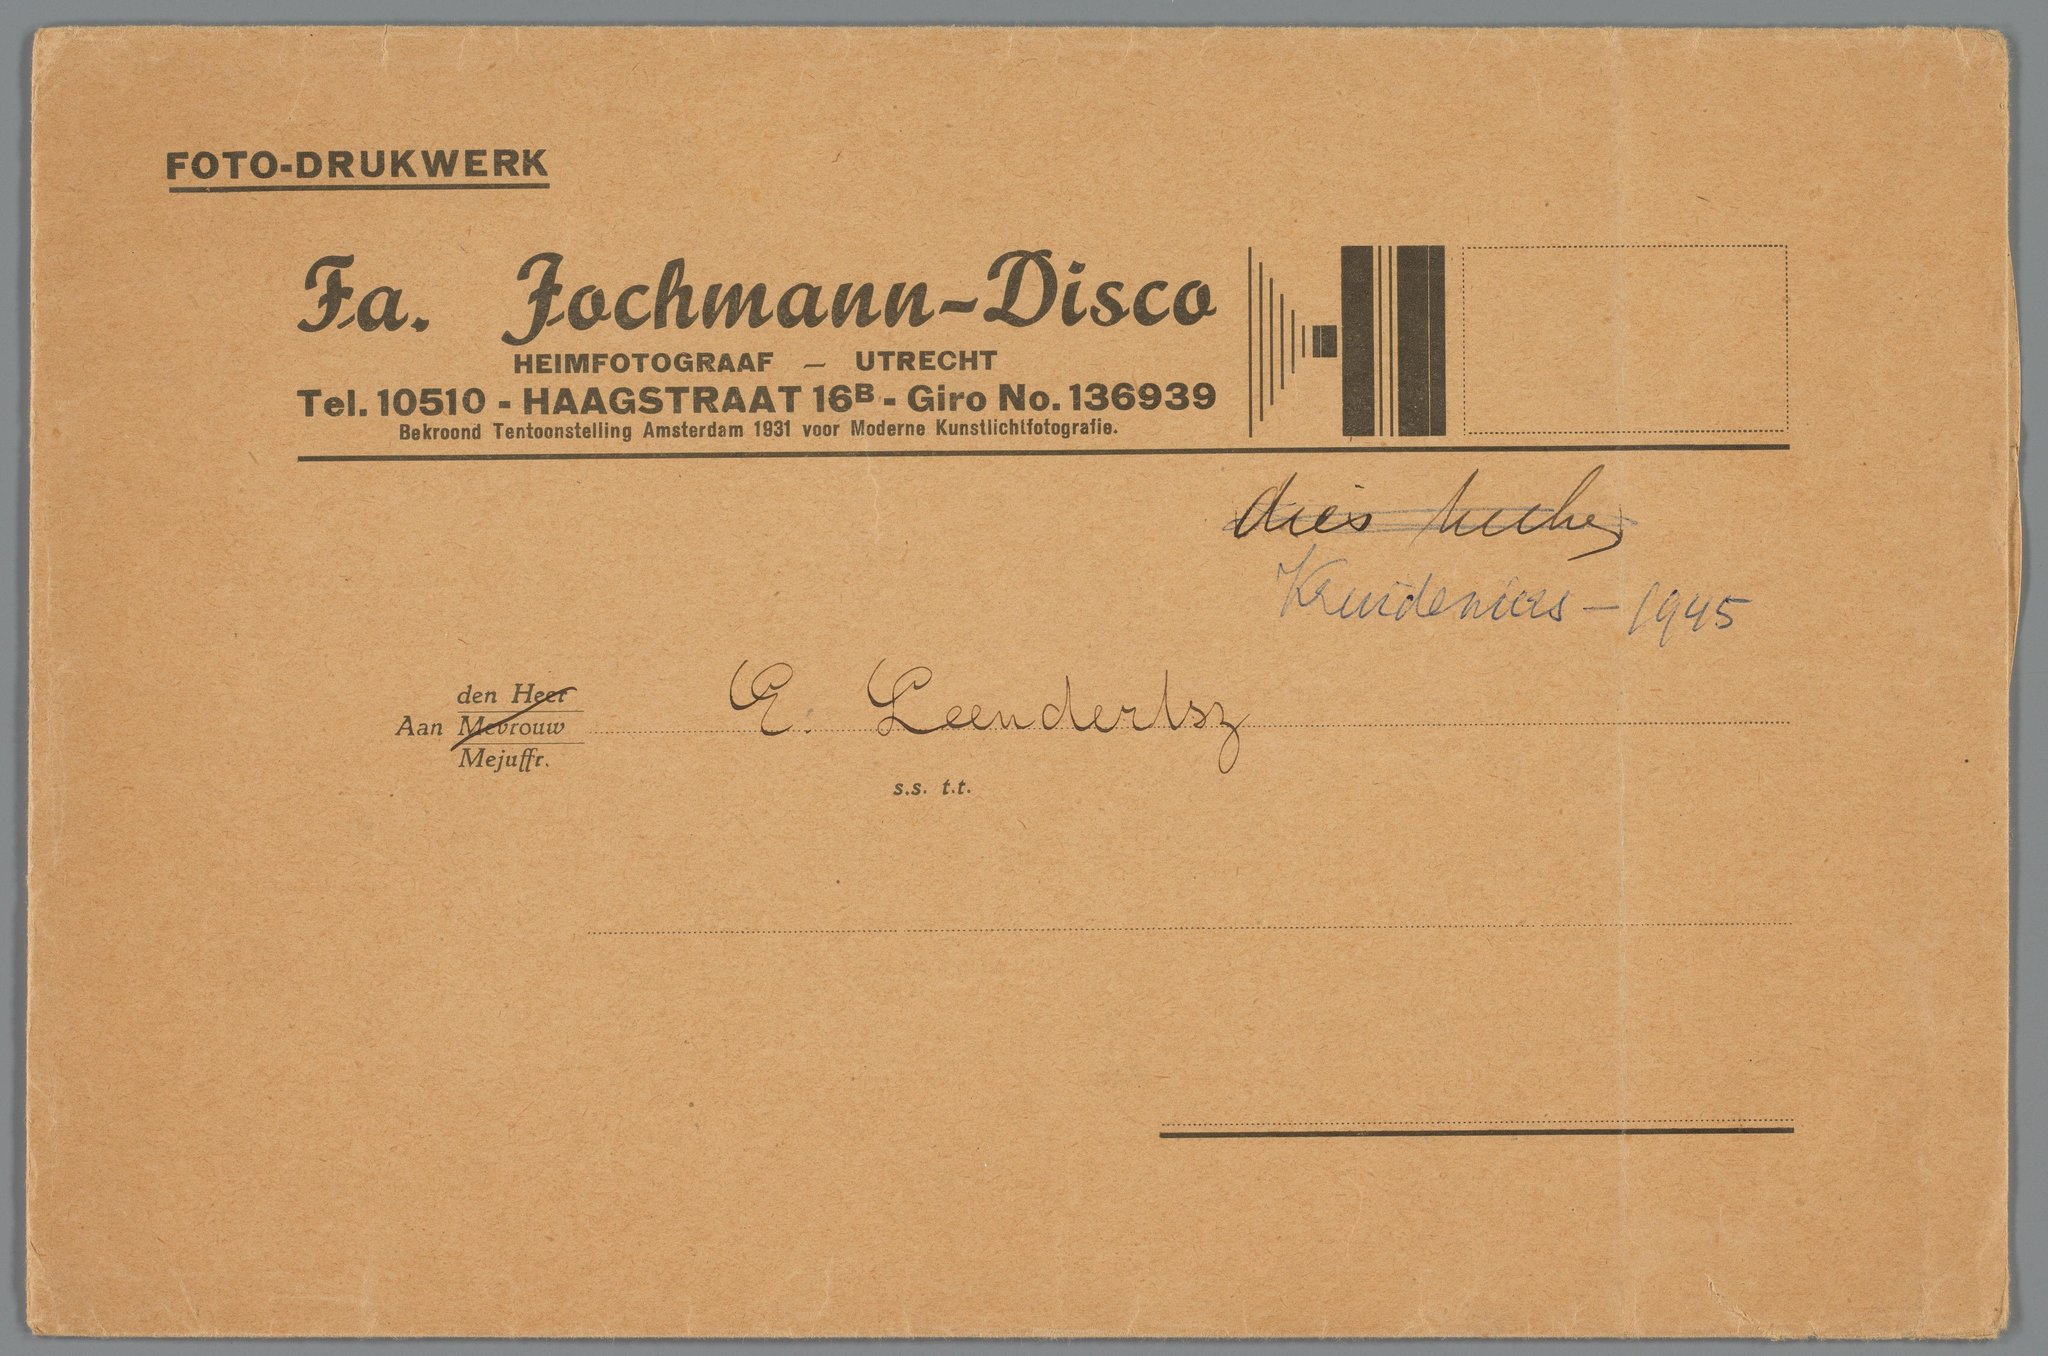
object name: envelope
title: Envelop van de fotostudio Jochmann-Disco uit Utrecht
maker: gustav johan erik jochmann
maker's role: fotograaf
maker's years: 1865-1941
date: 1931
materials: paper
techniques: printing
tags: letter, envelope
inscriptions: inscription: ‘Kruideniers - 1945/ E. Leendertsz’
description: Envelop voor fotodrukwerk van de Firma Jochmann-Disco uit Utrecht.